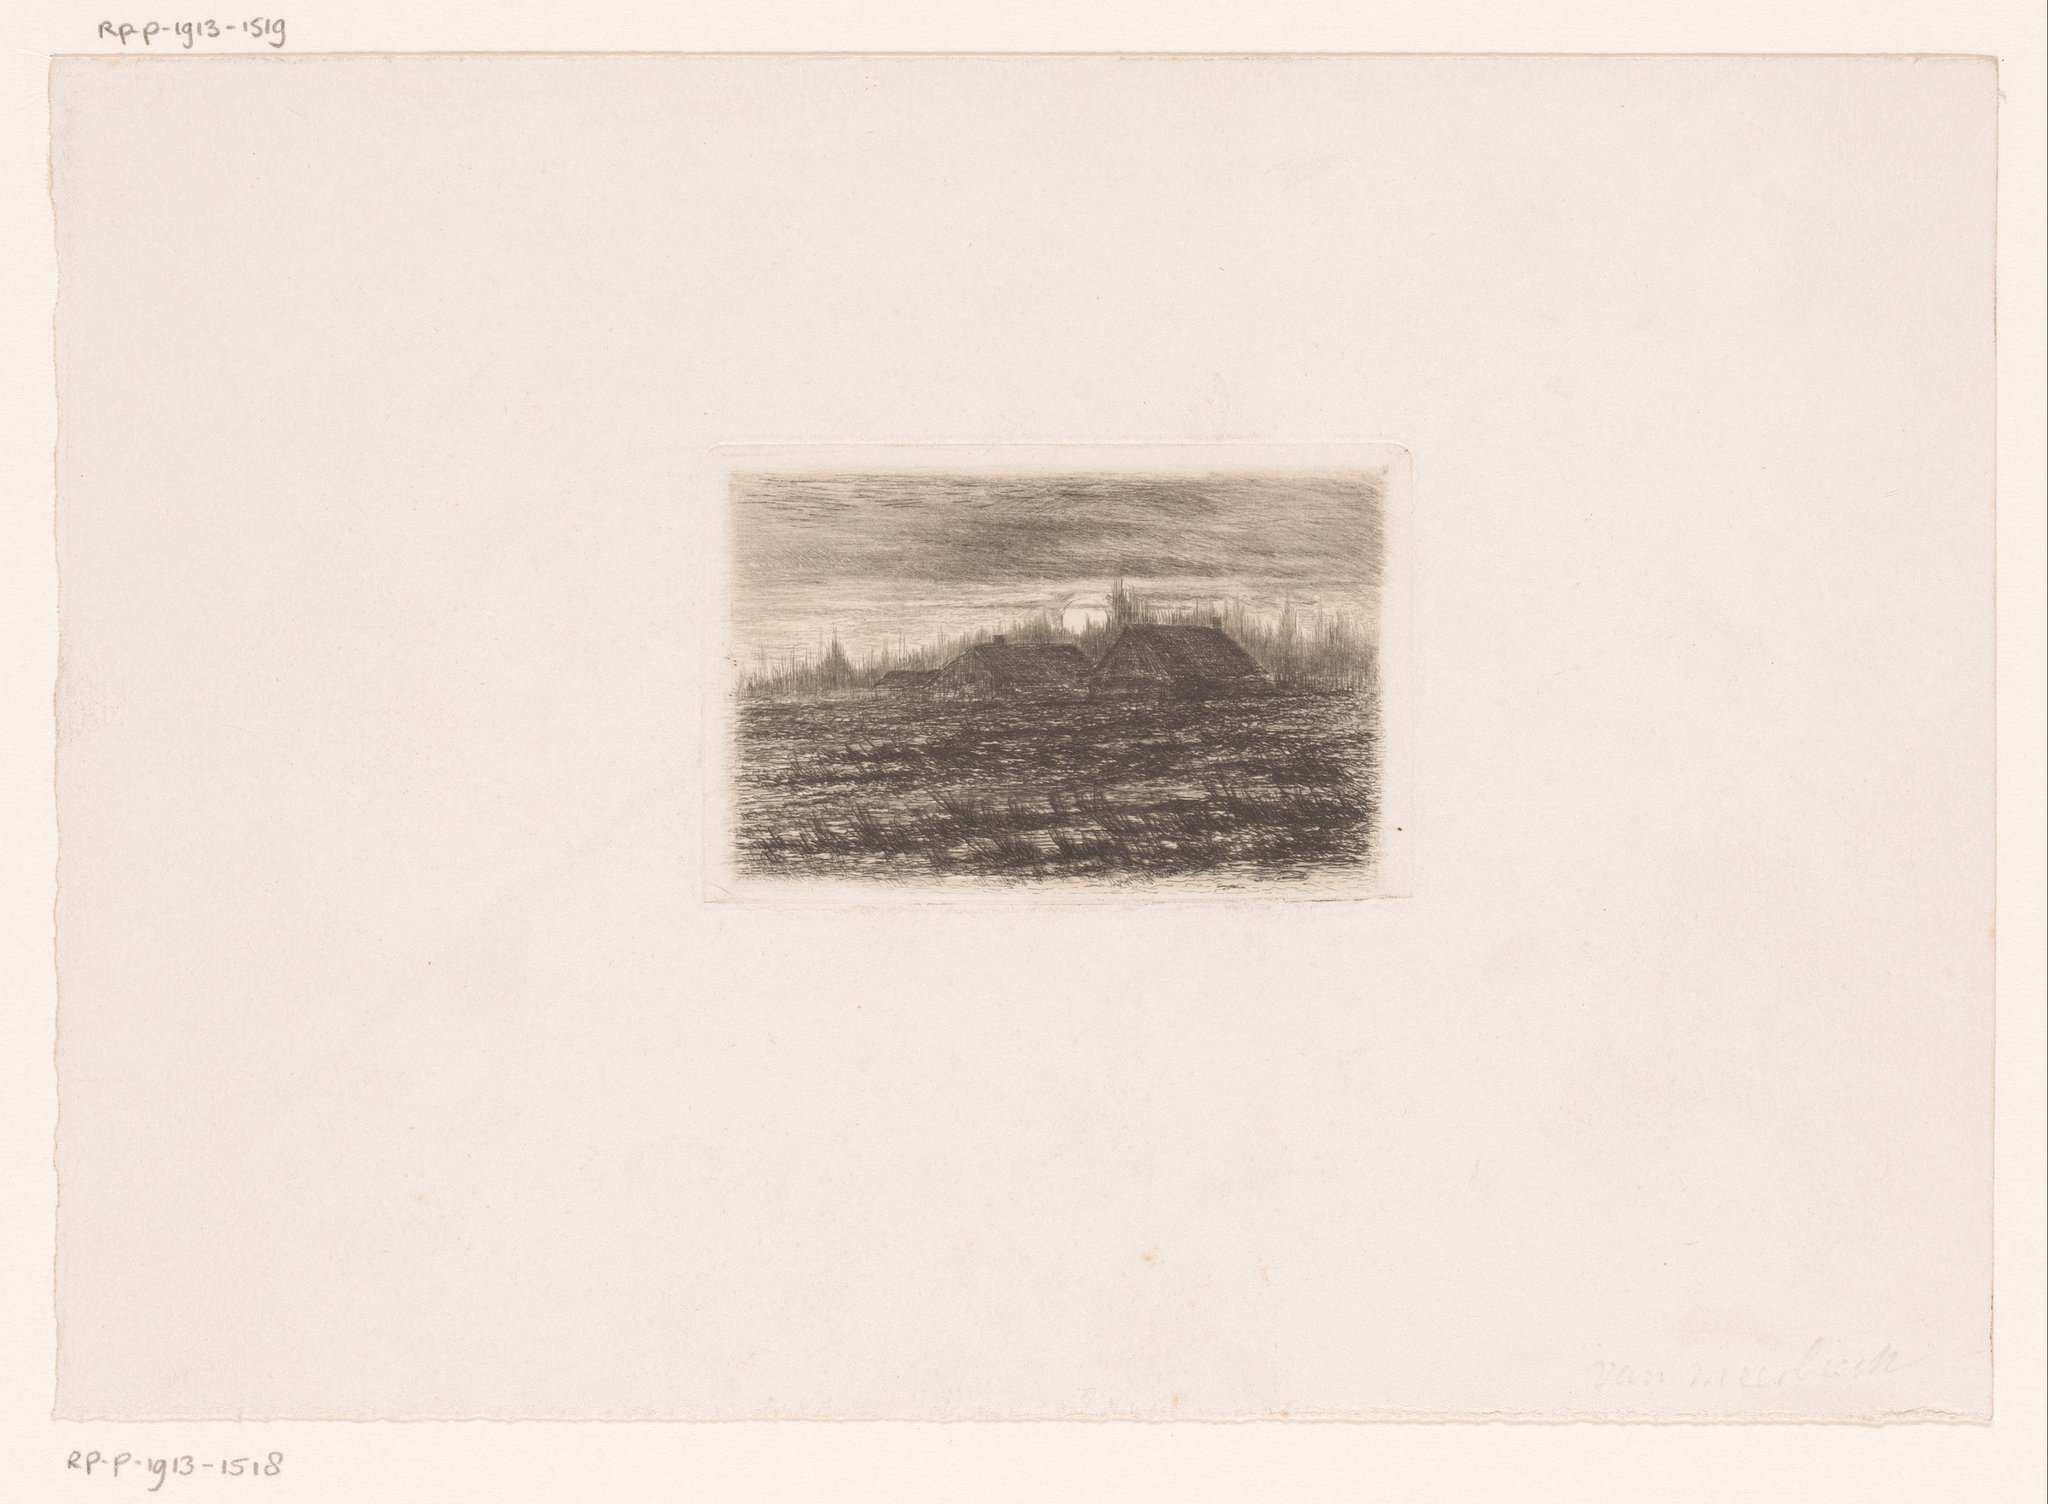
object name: print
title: Landschap met boerderijen bij maanlicht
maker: h. van meerbeeck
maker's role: print maker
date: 1850-1913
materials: paper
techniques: etching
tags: full moon, farm or solitary house in landscape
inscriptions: collector's mark: Lugt 2228